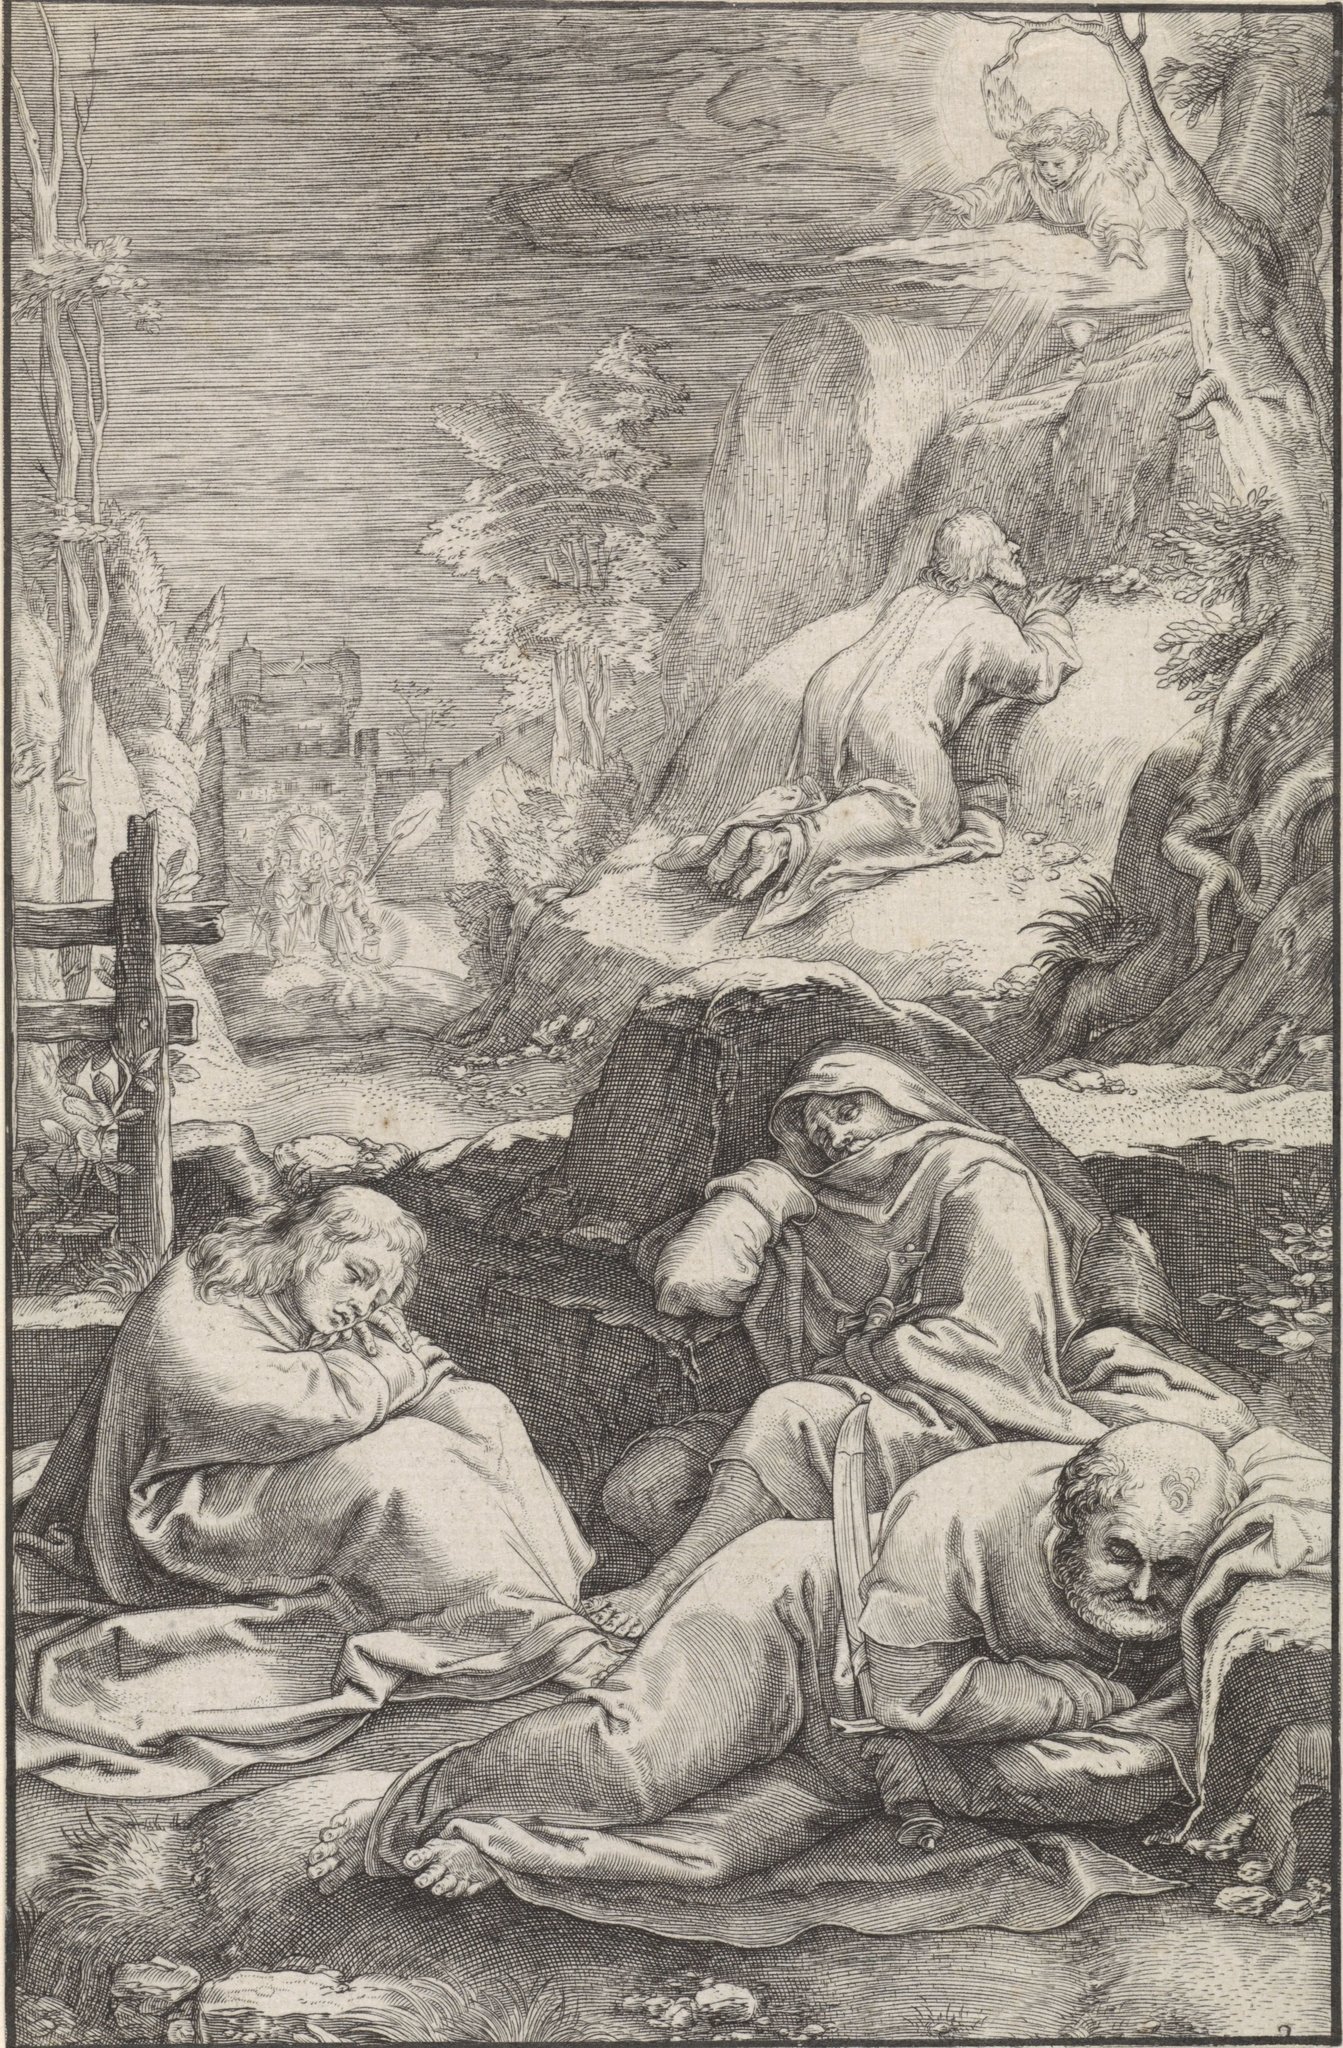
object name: print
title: Christus in de hof van Getsemane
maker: ludovicus siceram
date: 1623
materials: paper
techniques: engraving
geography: antwerp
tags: agony of christ; three (or eleven) apostles sleeping, agony of christ: to comfort him one or more angels appear to christ with chalice and/or cross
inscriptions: collector's mark: Lugt 2228a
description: Christus bidt in de hof van Getsemane. Een engel verschijnt aan hem en toont hem een kelk. Op de voorgrond drie slapende discipelen. Door de stadspoort rechts arriveert de groep soldaten.